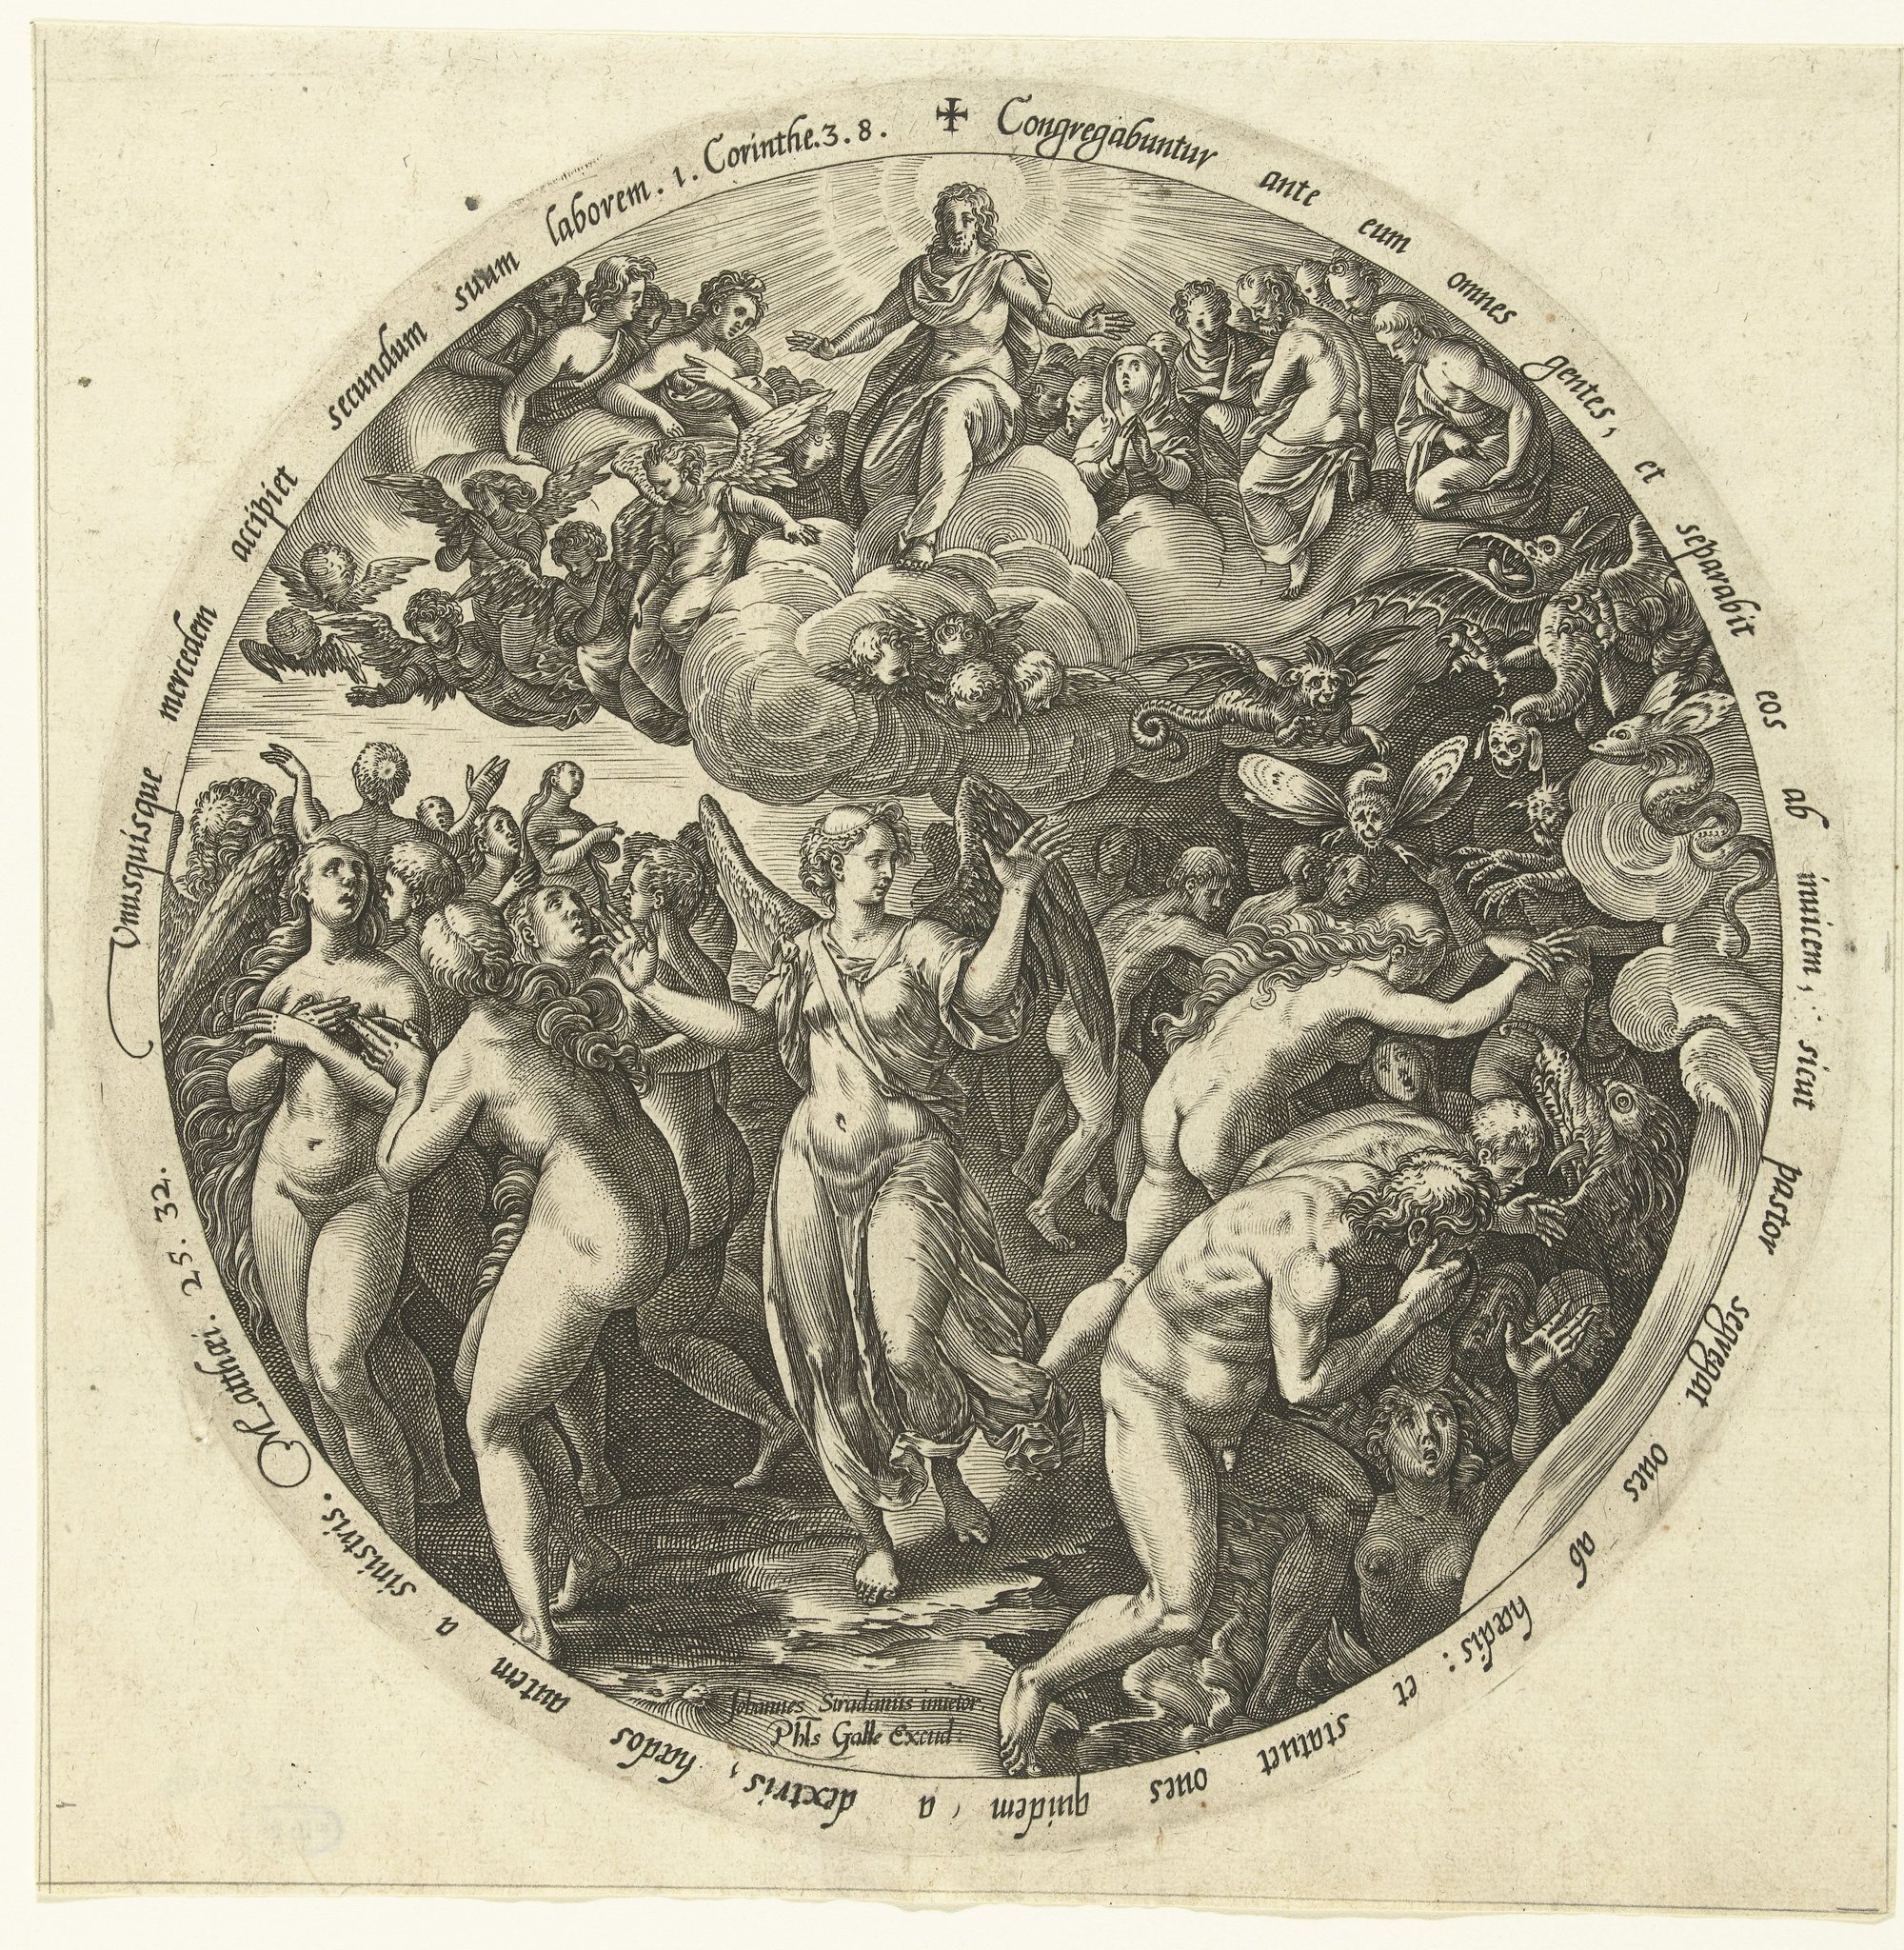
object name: print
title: De gezegenden worden gescheiden van de vervloekten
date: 1575-1579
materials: paper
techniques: engraving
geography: antwerp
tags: division of the blessed and the damned ~ last judgement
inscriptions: collector's mark: Lugt 2228a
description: Ronde voorstelling van de aartsengel Michaël die de zielen van de rechtvaardigen naar de hemel stuurt en de zielen van degenen die slecht geleefd hebben naar de hel. Helemaal bovenin de voorstelling Christus tronend in de hemel temidden van een schare heiligen (onder wie Maria) en engelen. Om de voorstelling bijbelteksten in het Latijn. Deze prent is onderdeel van een serie van vier ronde prenten met Laatste Oordeelscènes.